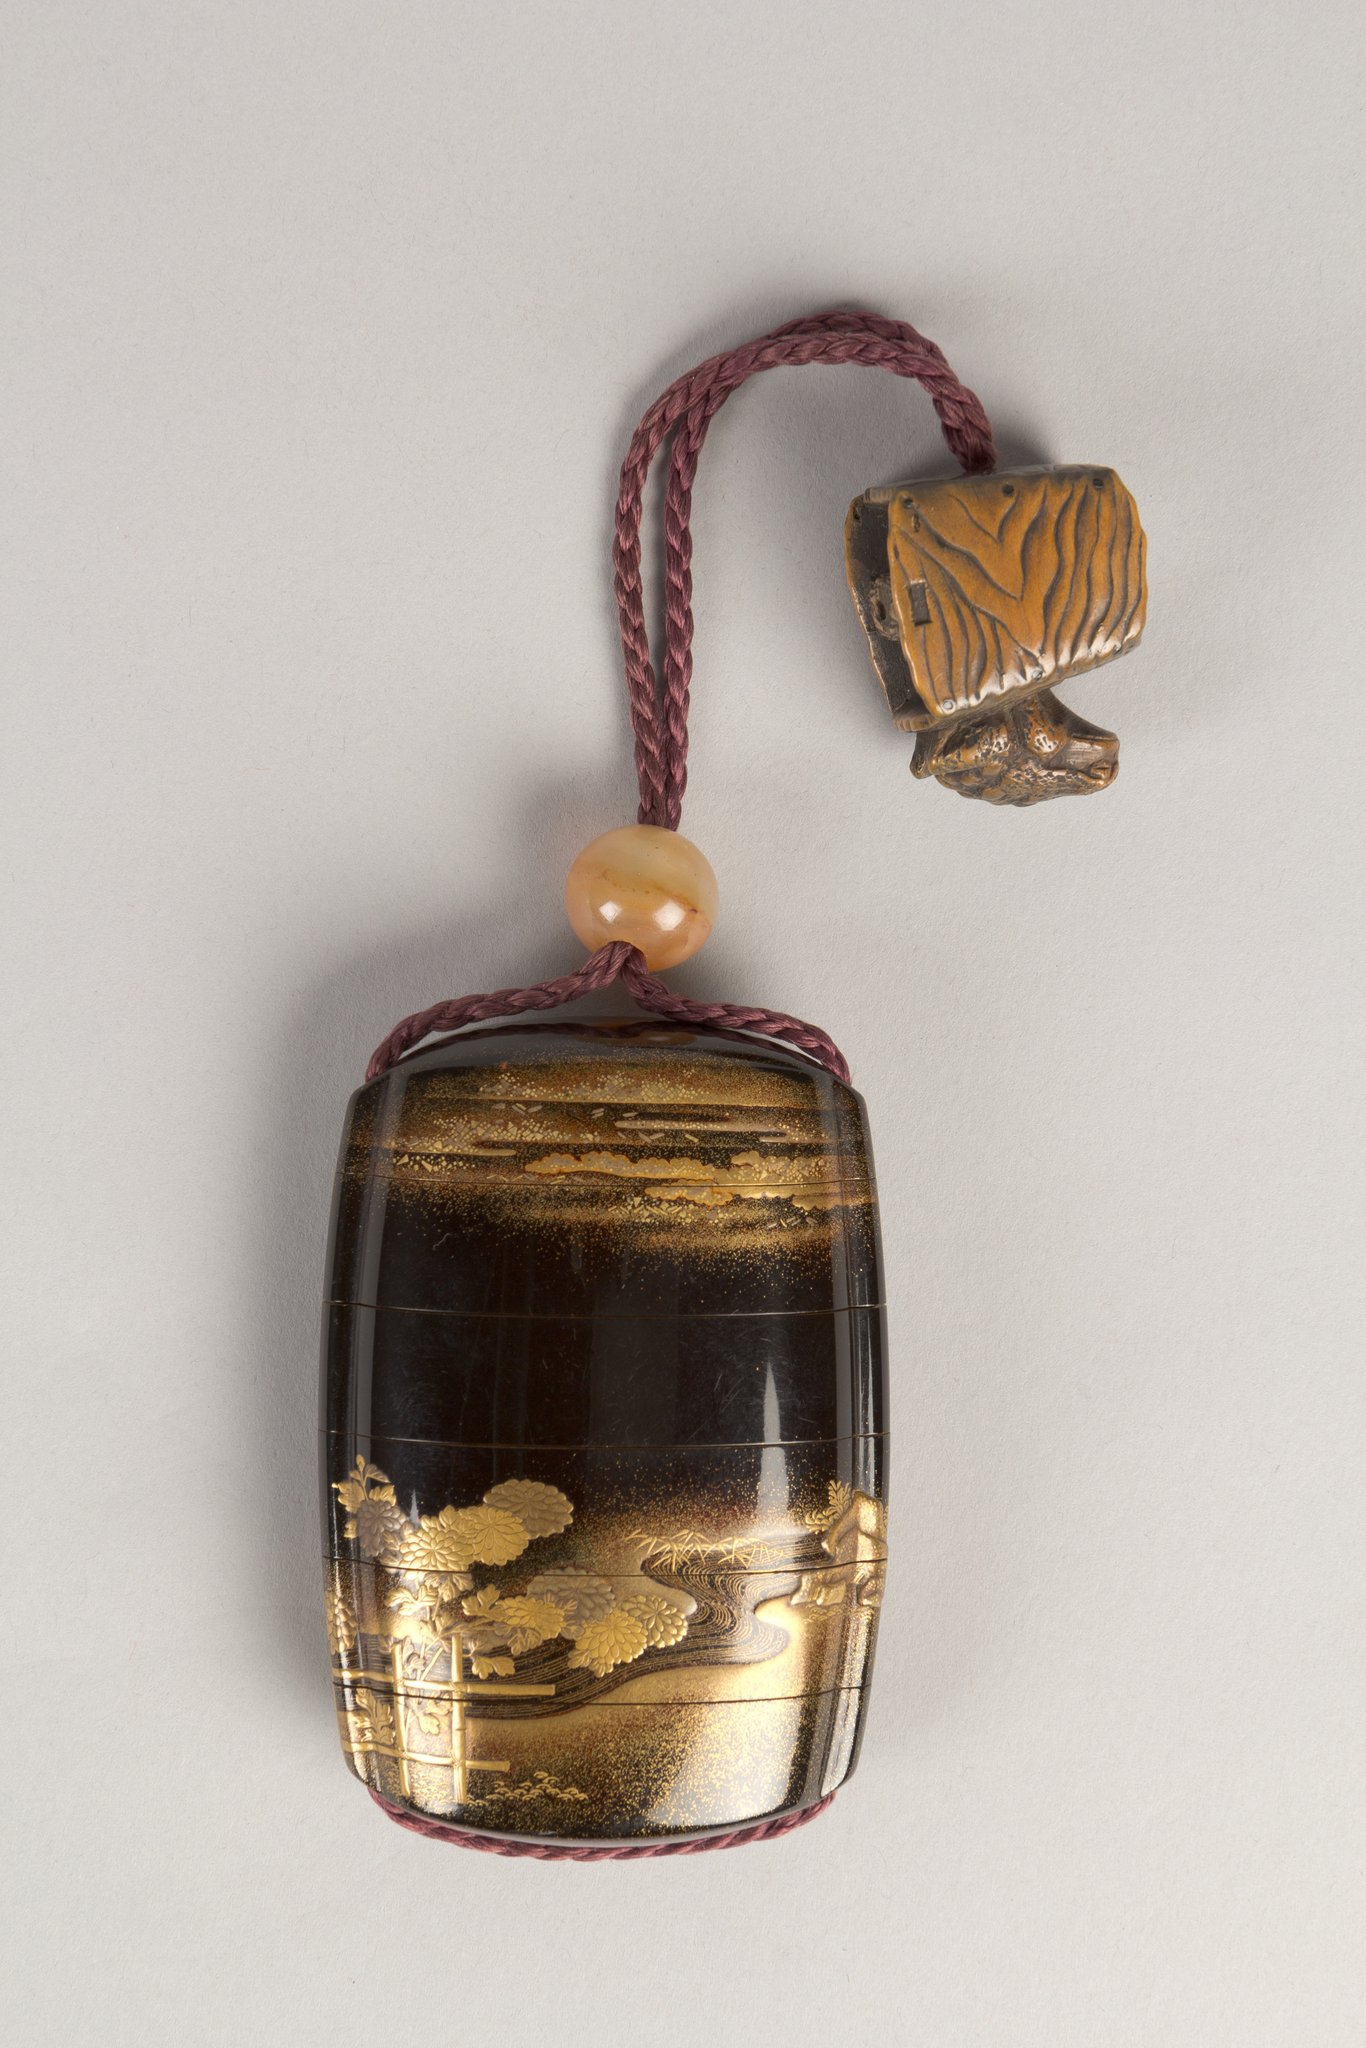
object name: inrō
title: Case (Inrō) with Design of Chrysanthemums by a Stream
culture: japanese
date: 1801-1900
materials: stone, gold, lacquer, wood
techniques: carving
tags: flowers